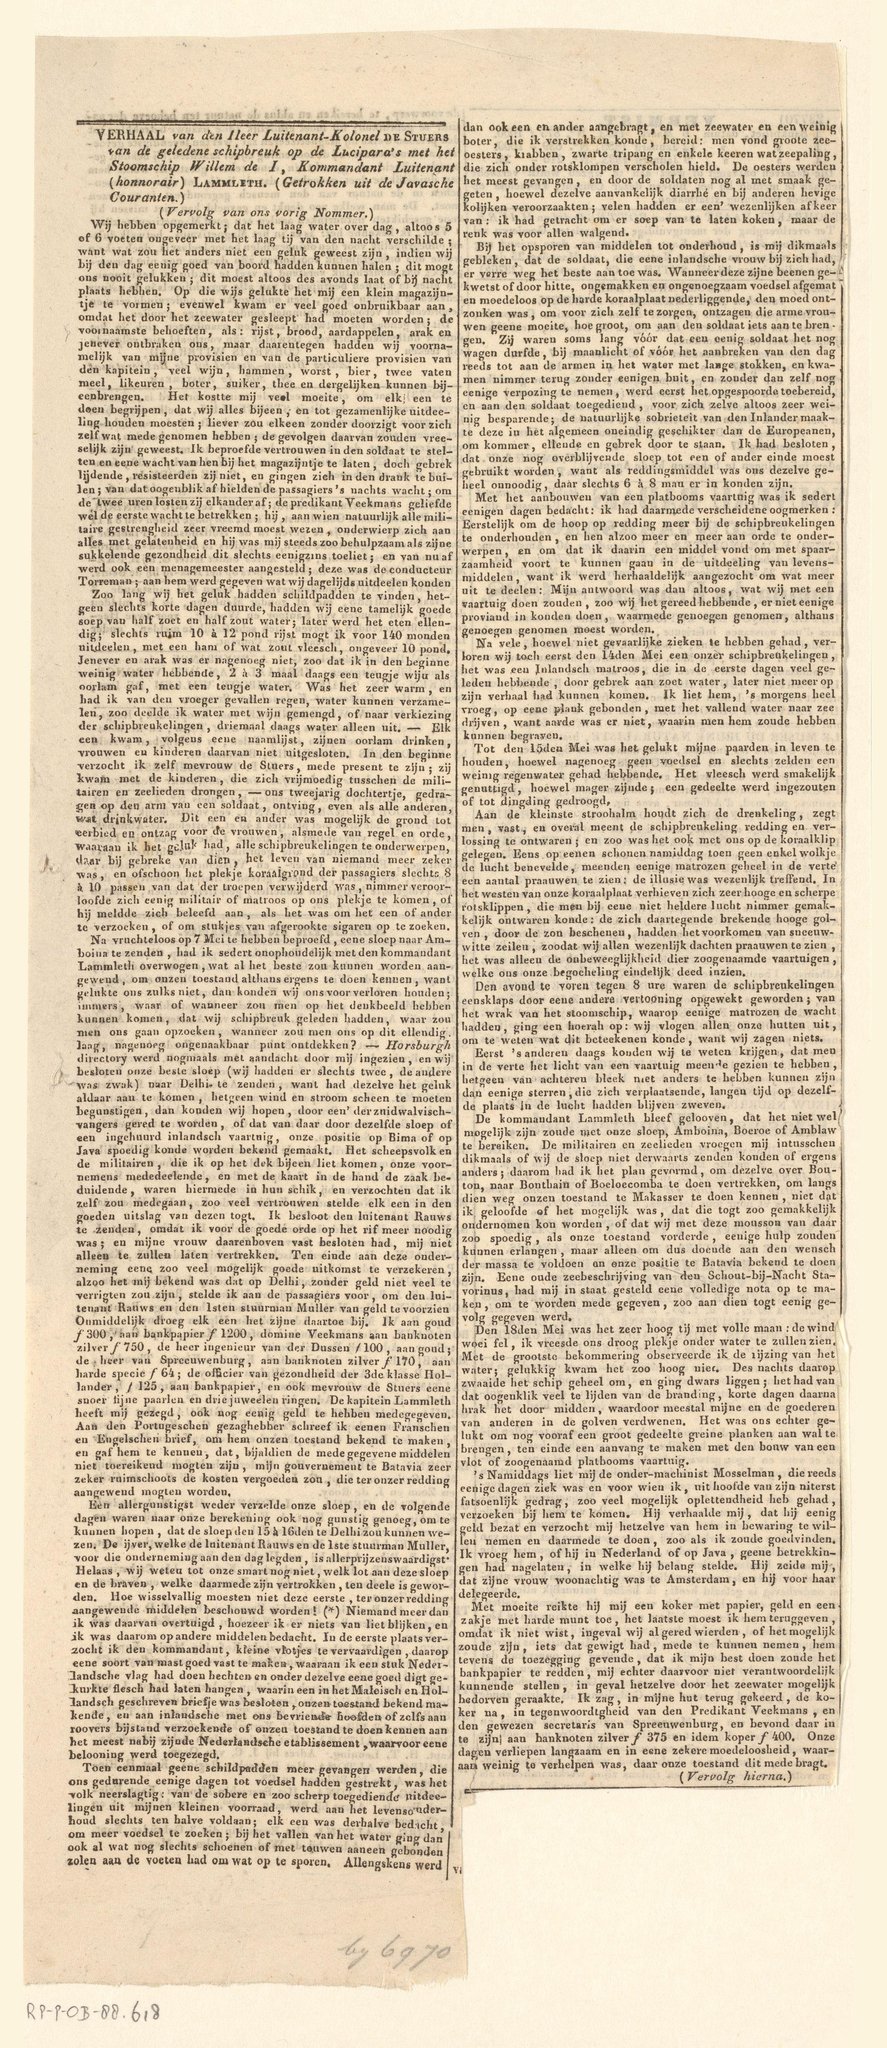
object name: newspaper clipping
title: Krantenknipsel over de schipbreuk van het stoomschip Willem I, 1837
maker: christiaan andersen spin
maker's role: printer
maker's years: 1792-1865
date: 1812-1837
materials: paper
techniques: letterpress printing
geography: amsterdam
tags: willem i (schip), lucipara, kepulauan, schipbreuk van de willem i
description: Krantenknipsel uit het Algemeen Handelsblad van december 1837 met het verhaal van de schipbreuk van het raderstoomschip Willem I in de nacht van 5 op 6 mei 1837 op de Lucipara eilanden.